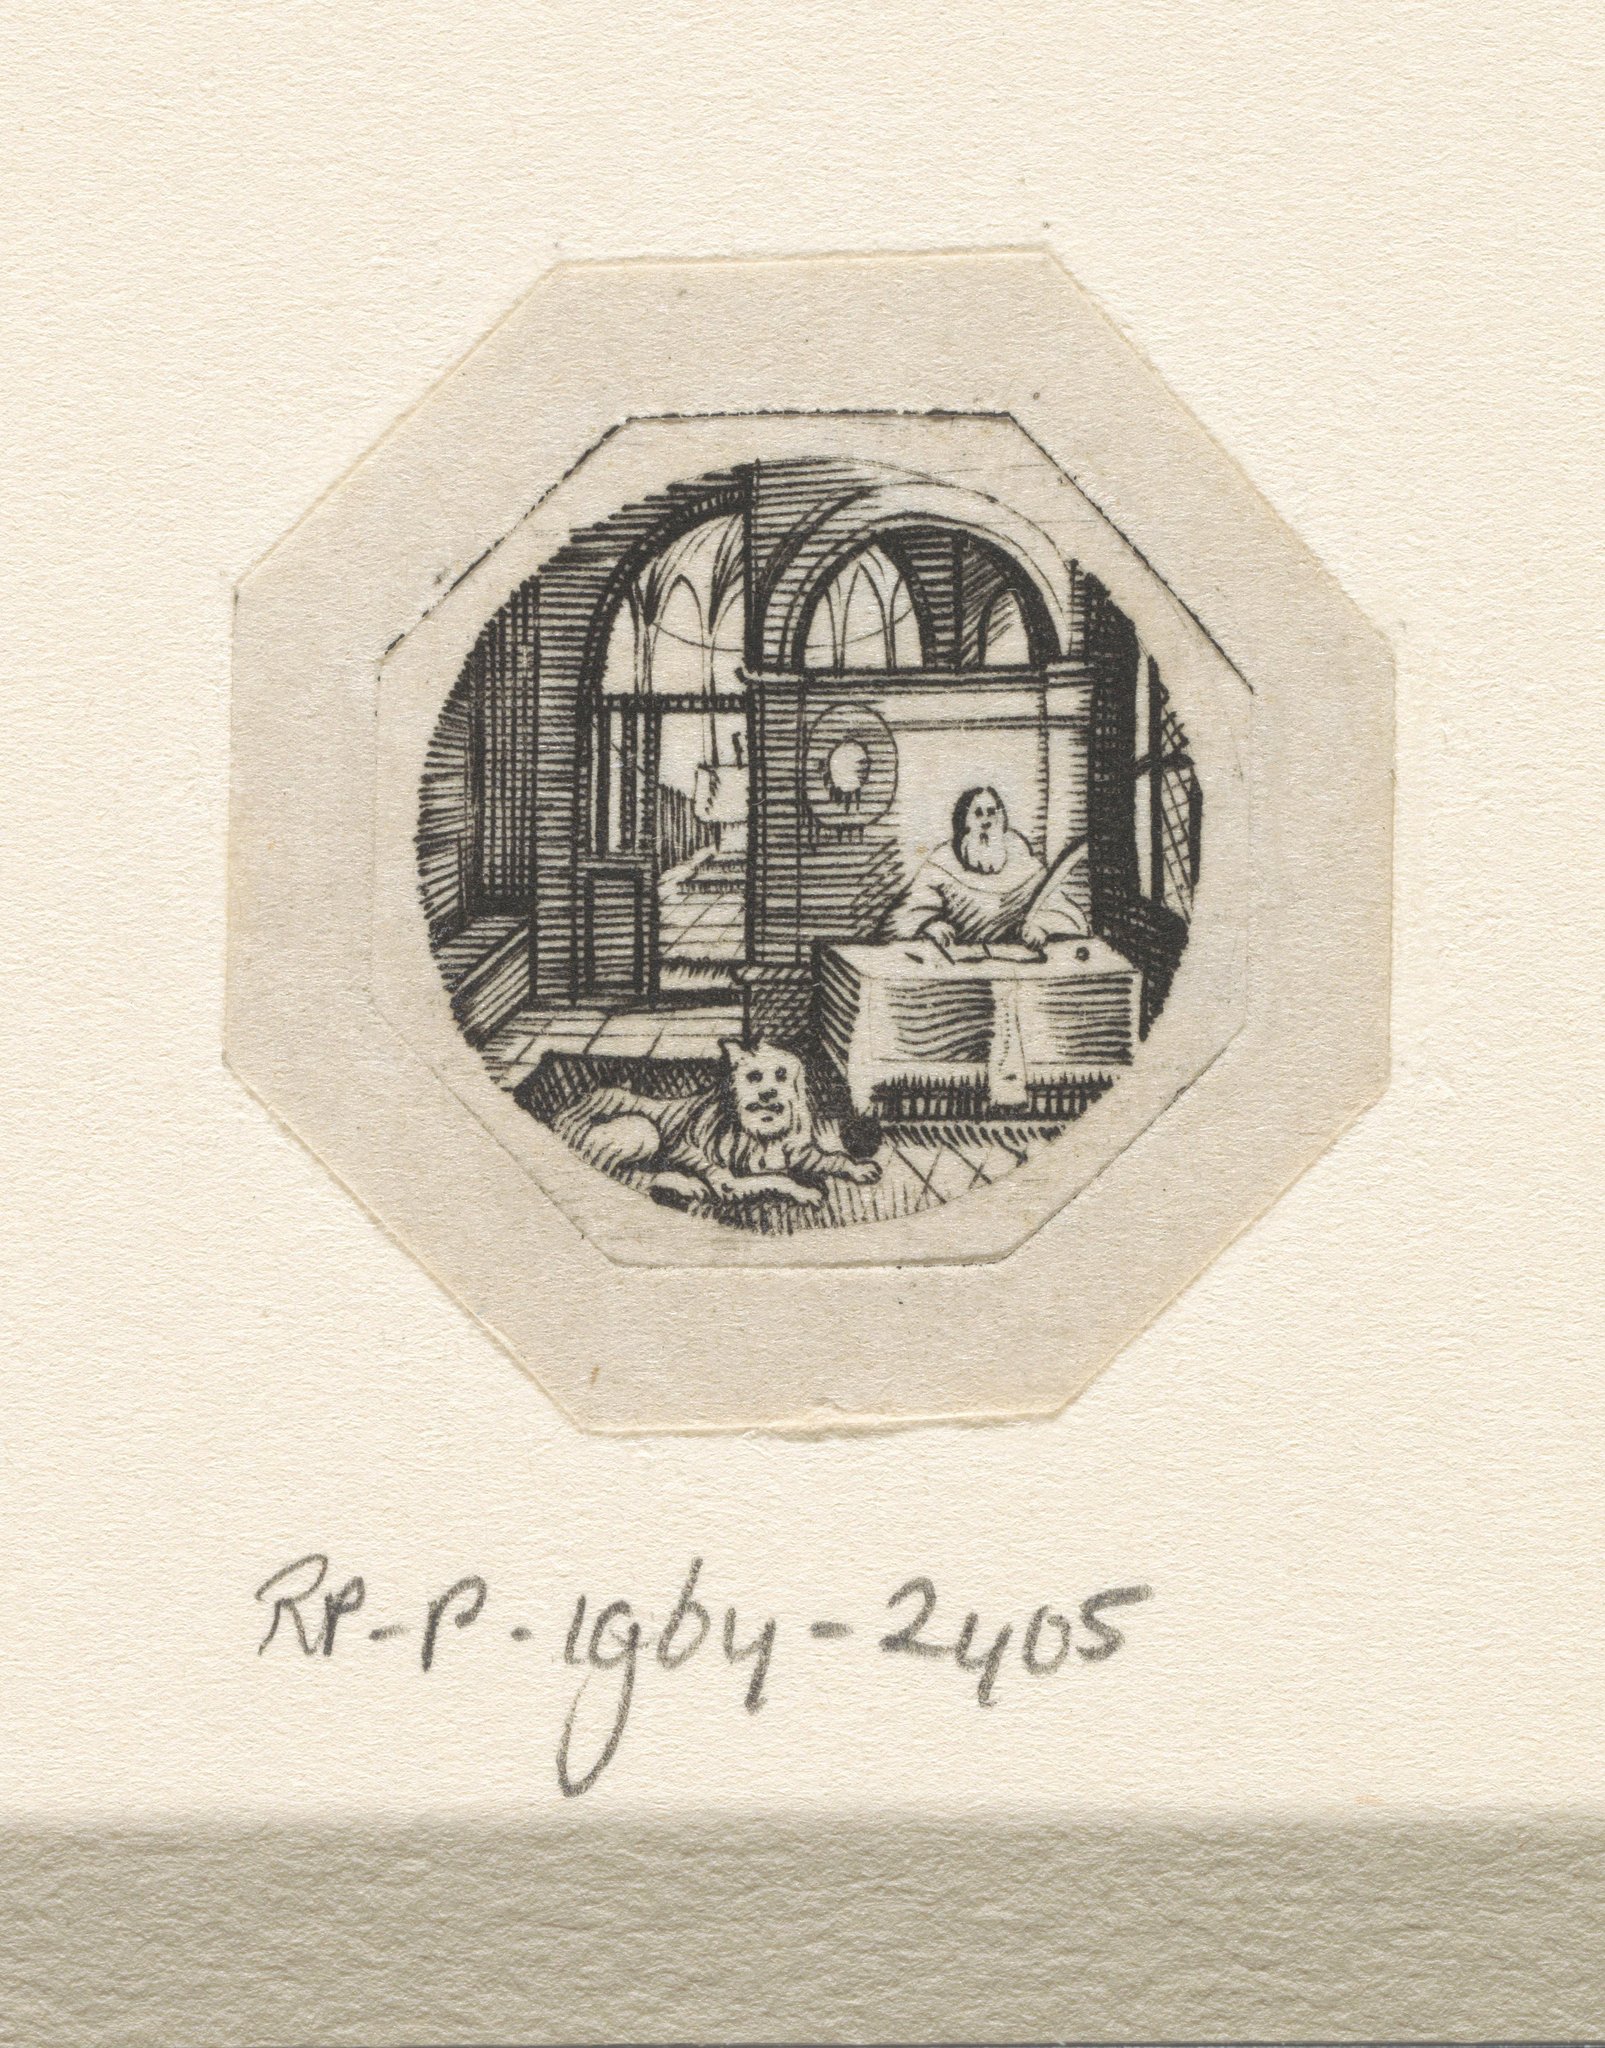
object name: print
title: Schrijvende kerkvader Hieronymus in een interieur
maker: isaac walraven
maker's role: draughtsman, painter, print maker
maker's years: 1686-1765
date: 1696-1765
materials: paper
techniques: engraving, etching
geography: amsterdam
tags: the monk and hermit jerome (hieronymus); possible attributes: book, cardinal's hat, crucifix, hour-glass, lion, skull, stone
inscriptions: collector's mark: Lugt 2228, collector's mark: Lugt 2760